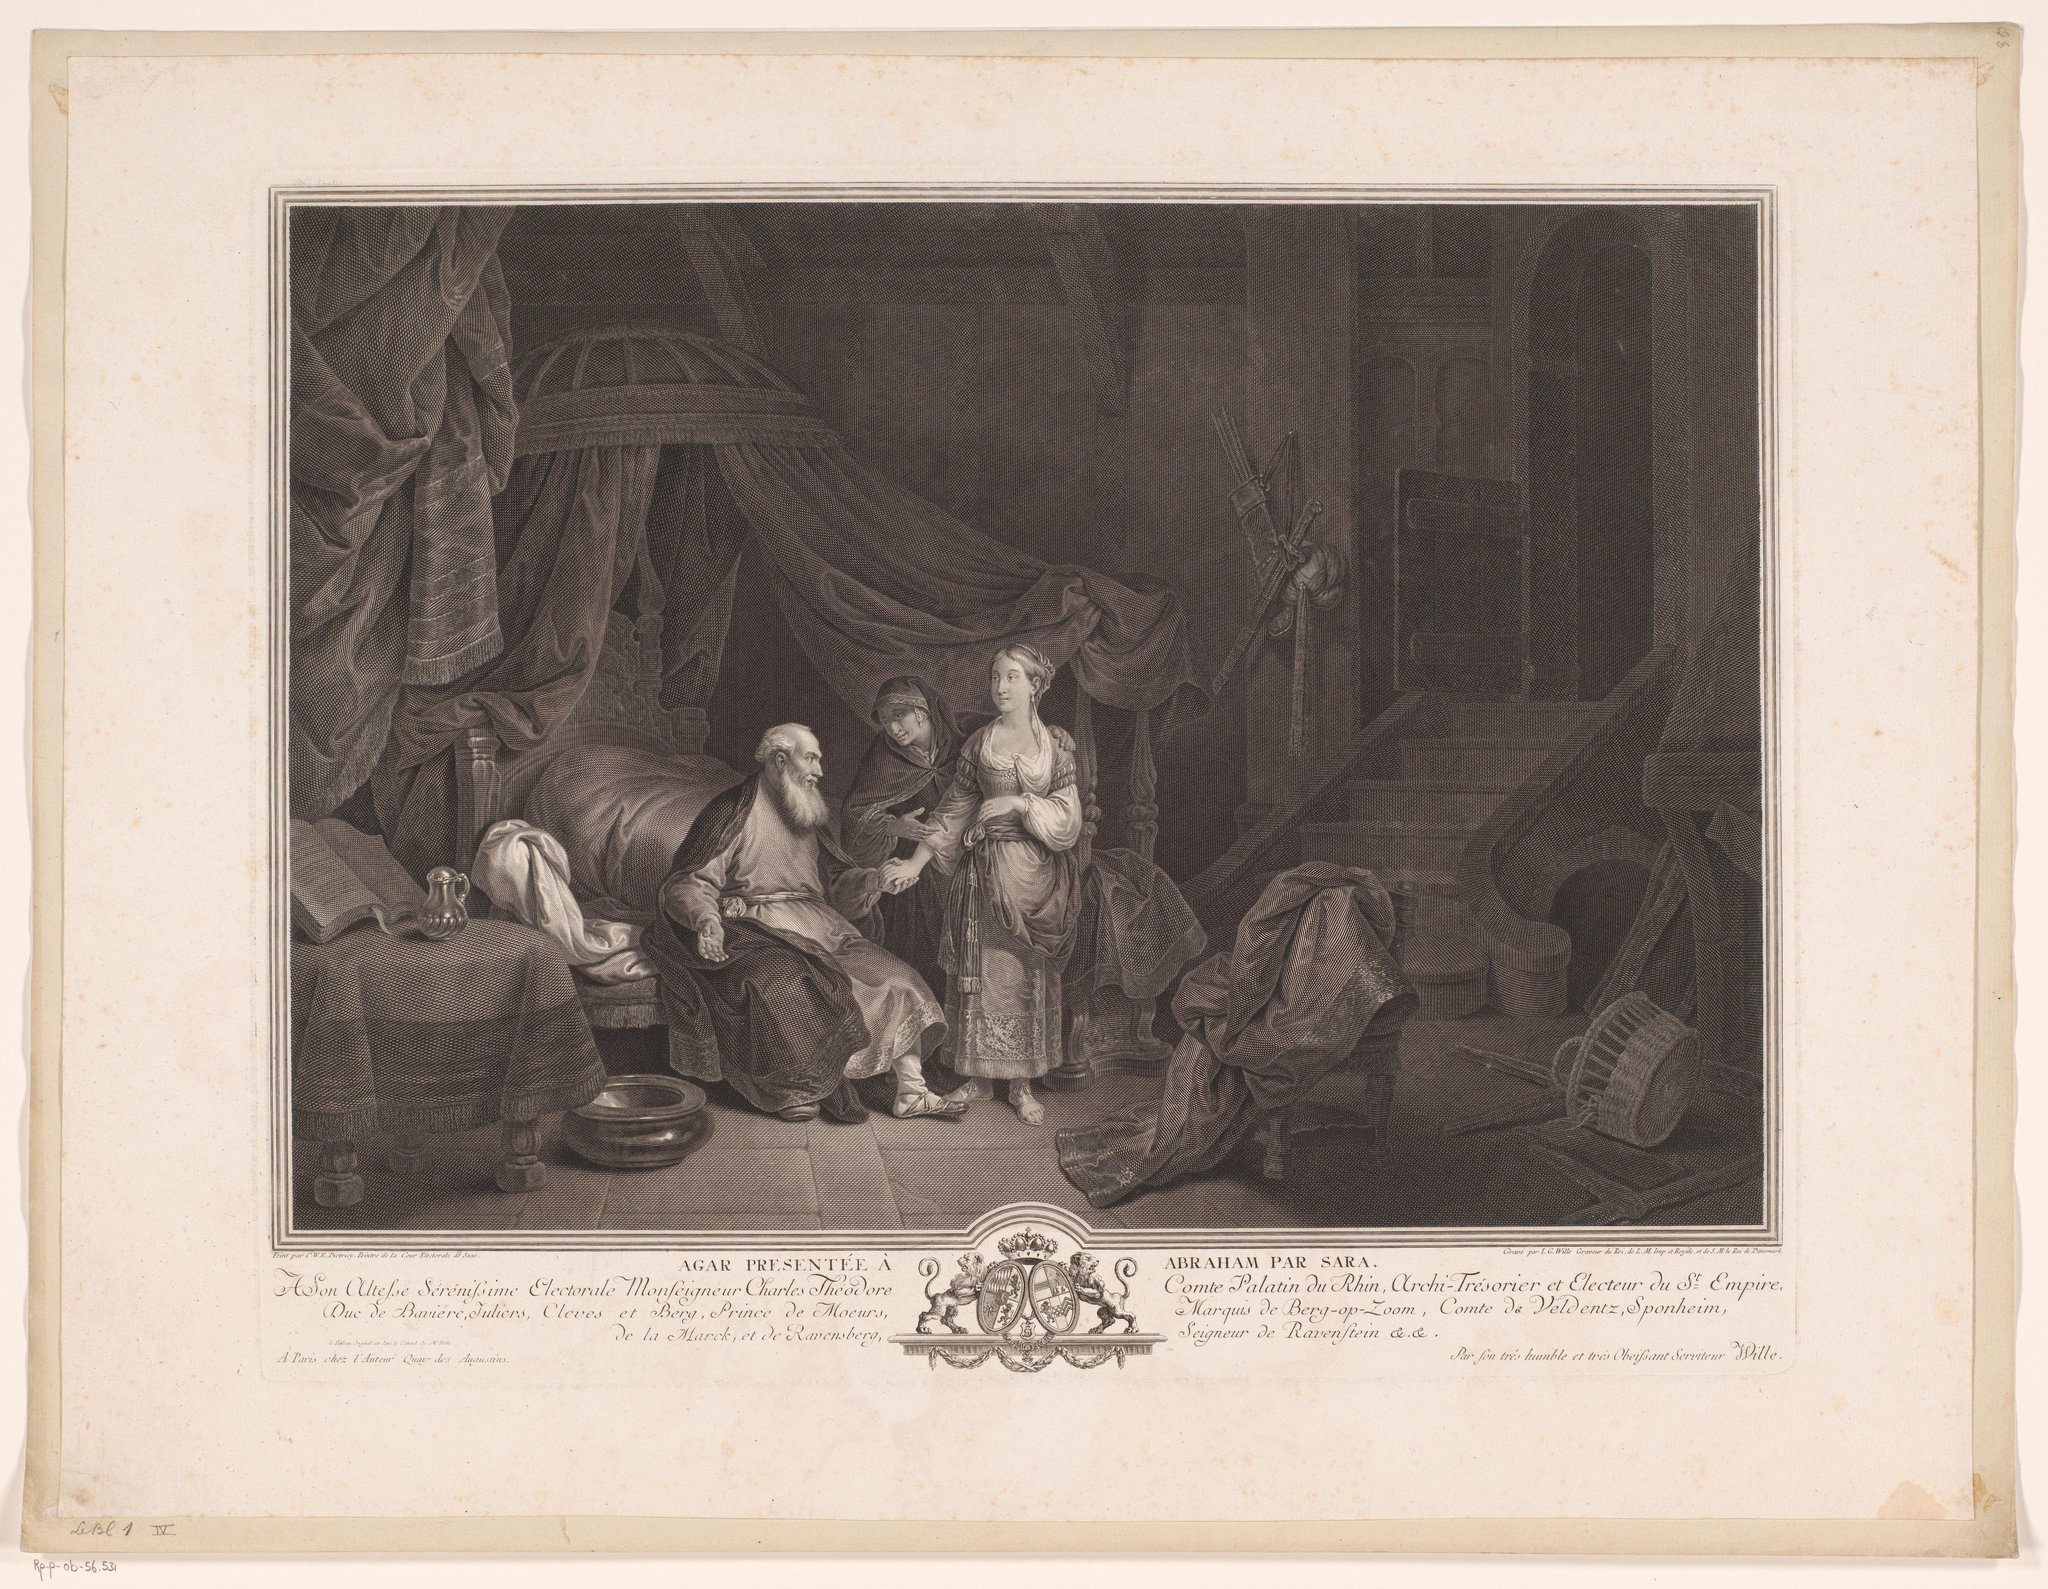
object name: print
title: Sara stelt Hagar voor aan Abraham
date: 1775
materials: paper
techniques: engraving, etching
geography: paris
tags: sarah brings hagar to abraham, who is usually shown lying in bed, armorial bearing, heraldry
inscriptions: collector's mark: Lugt 240